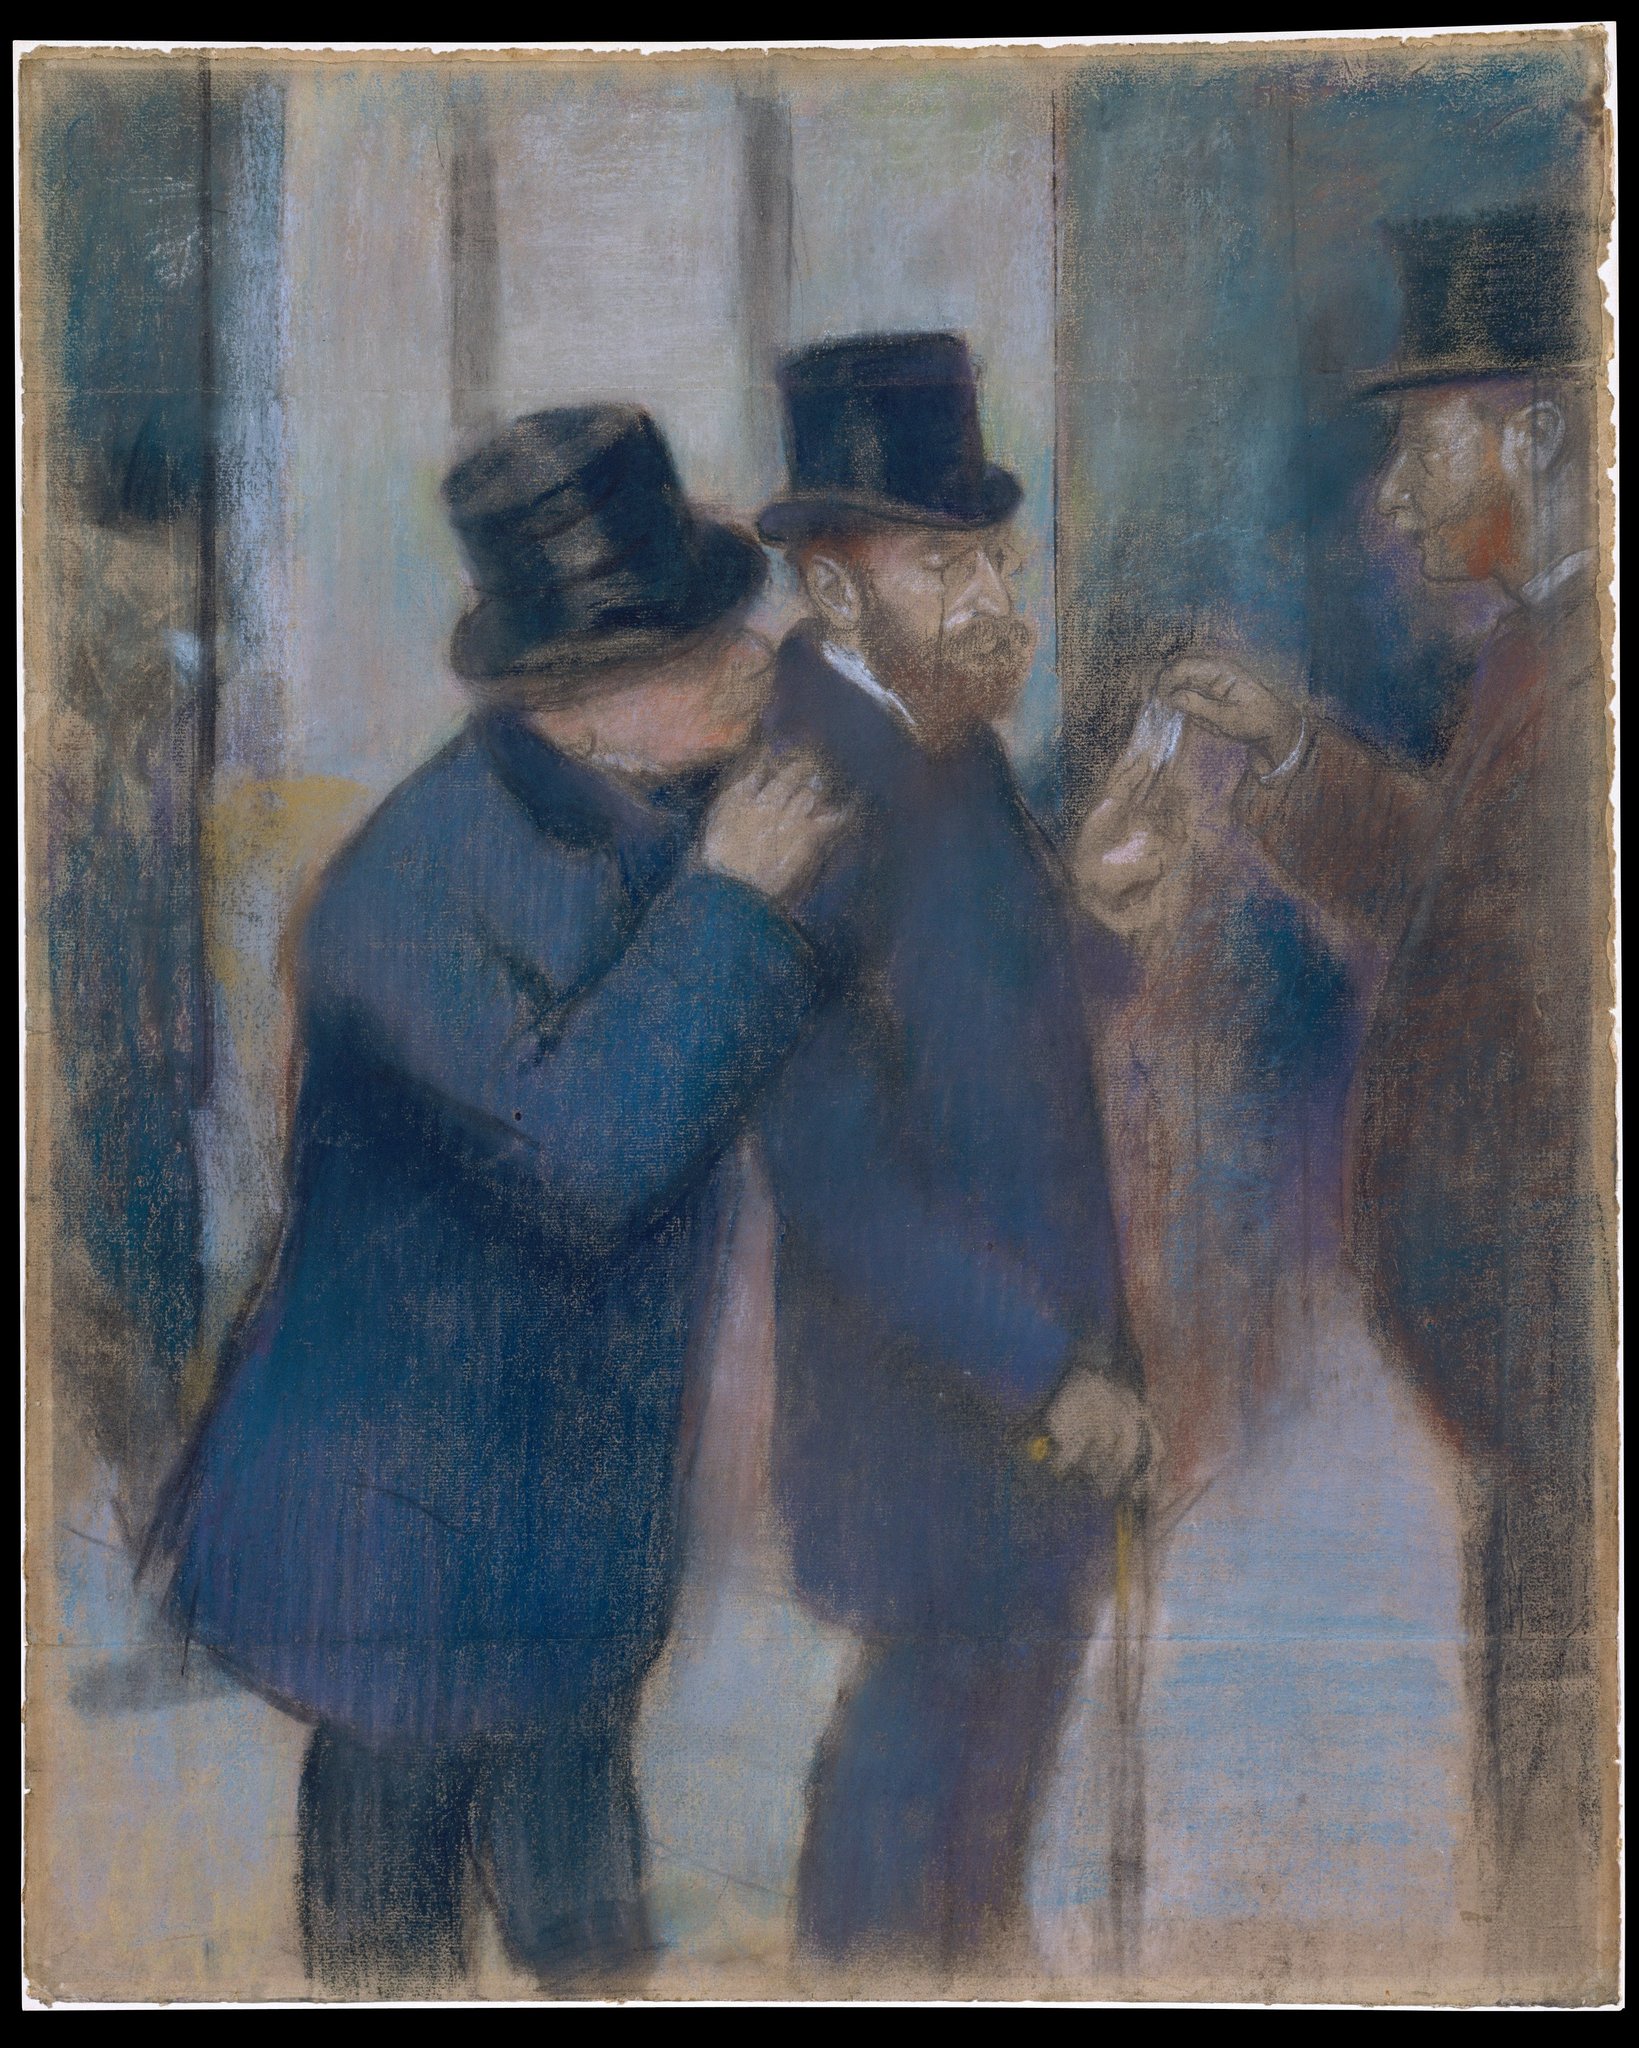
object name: drawing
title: Portraits at the Stock Exchange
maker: edgar degas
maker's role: artist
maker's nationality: french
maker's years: 1834-1917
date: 1878-1879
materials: canvas, paper, pastel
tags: men